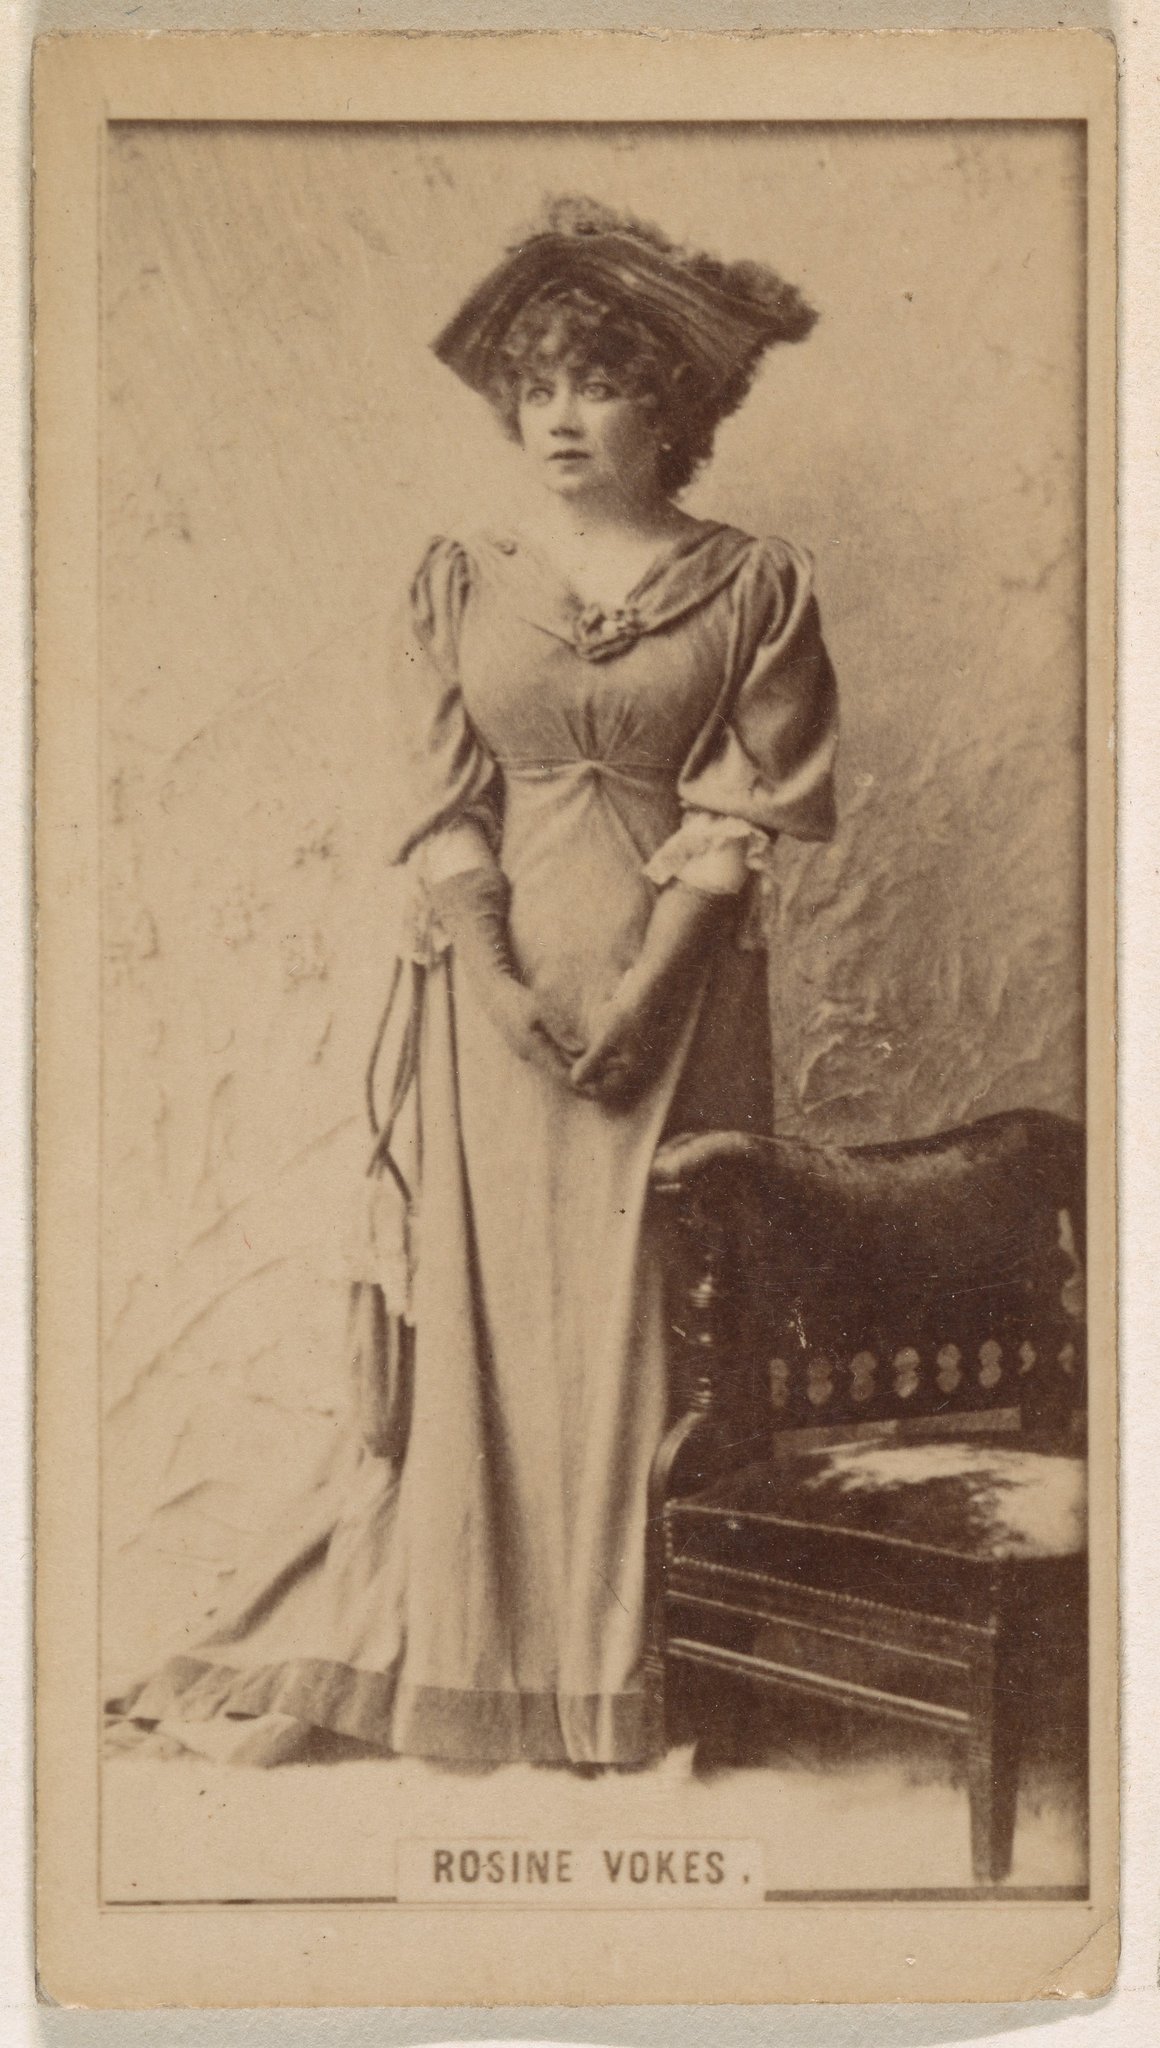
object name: photograph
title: Rosine Vokes, from the Actresses series (N245) issued by Kinney Brothers to promote Sweet Caporal Cigarettes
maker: kinney brothers tobacco company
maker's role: publisher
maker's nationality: american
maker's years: 1869-2011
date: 1890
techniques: albumen silver print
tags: portraits,women,actresses